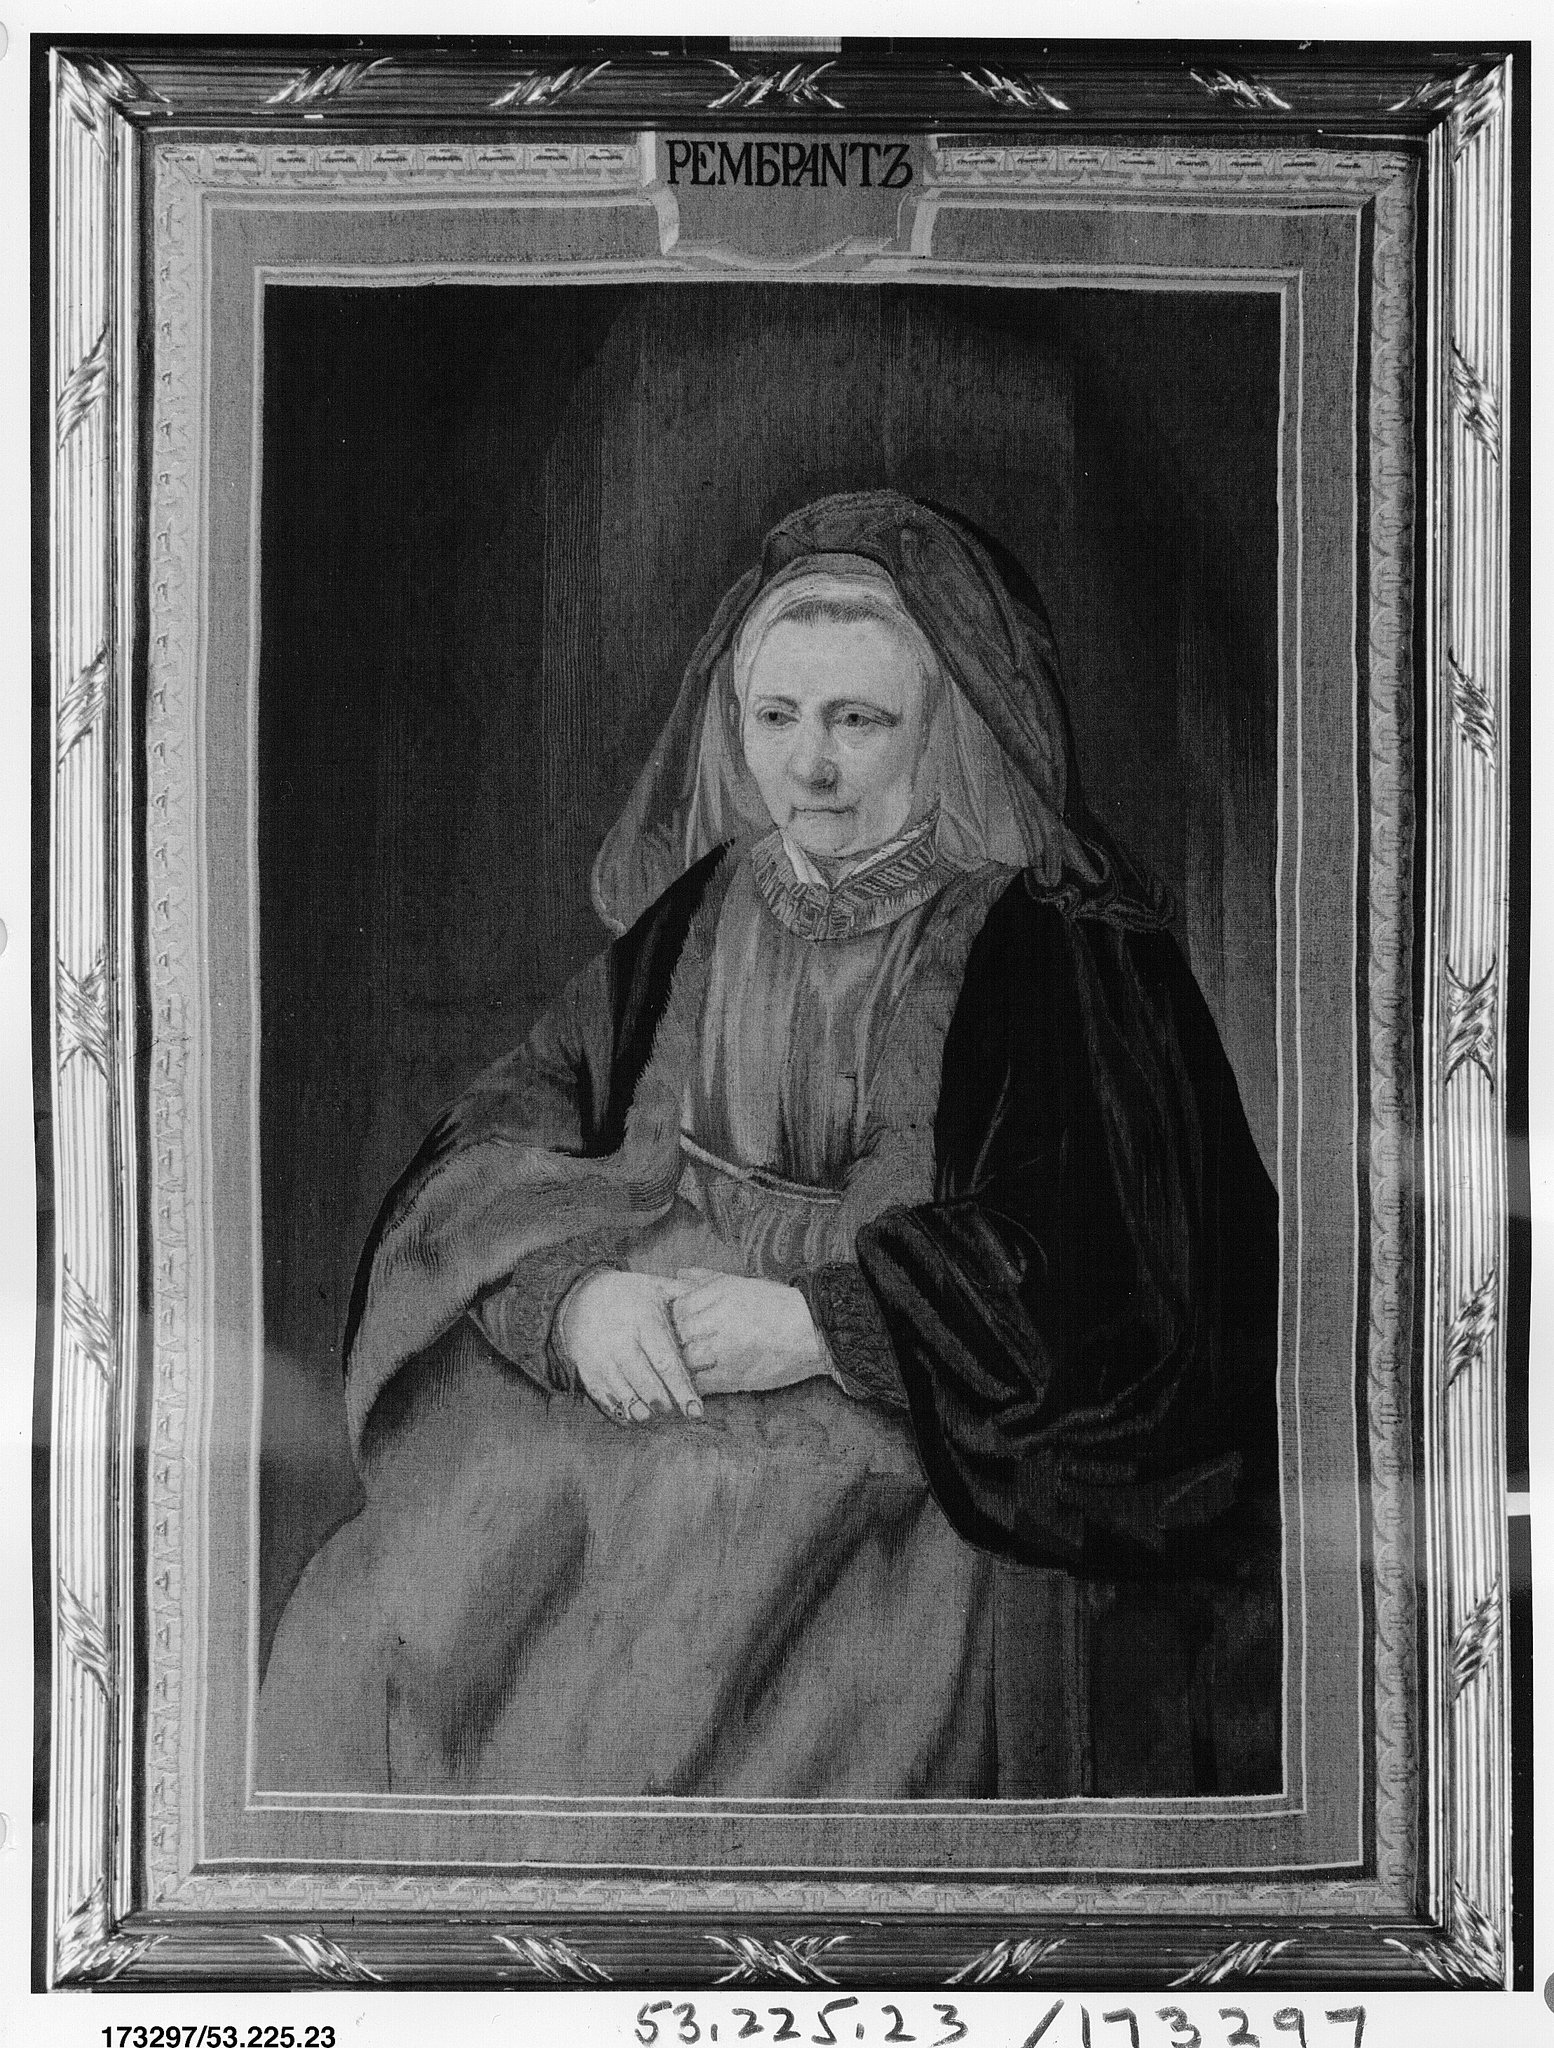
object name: tapestry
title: Old Woman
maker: imperial russian tapestry manufactory, saint petersburg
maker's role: manufactory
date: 1767-1800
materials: metal thread, wool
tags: portraits,women